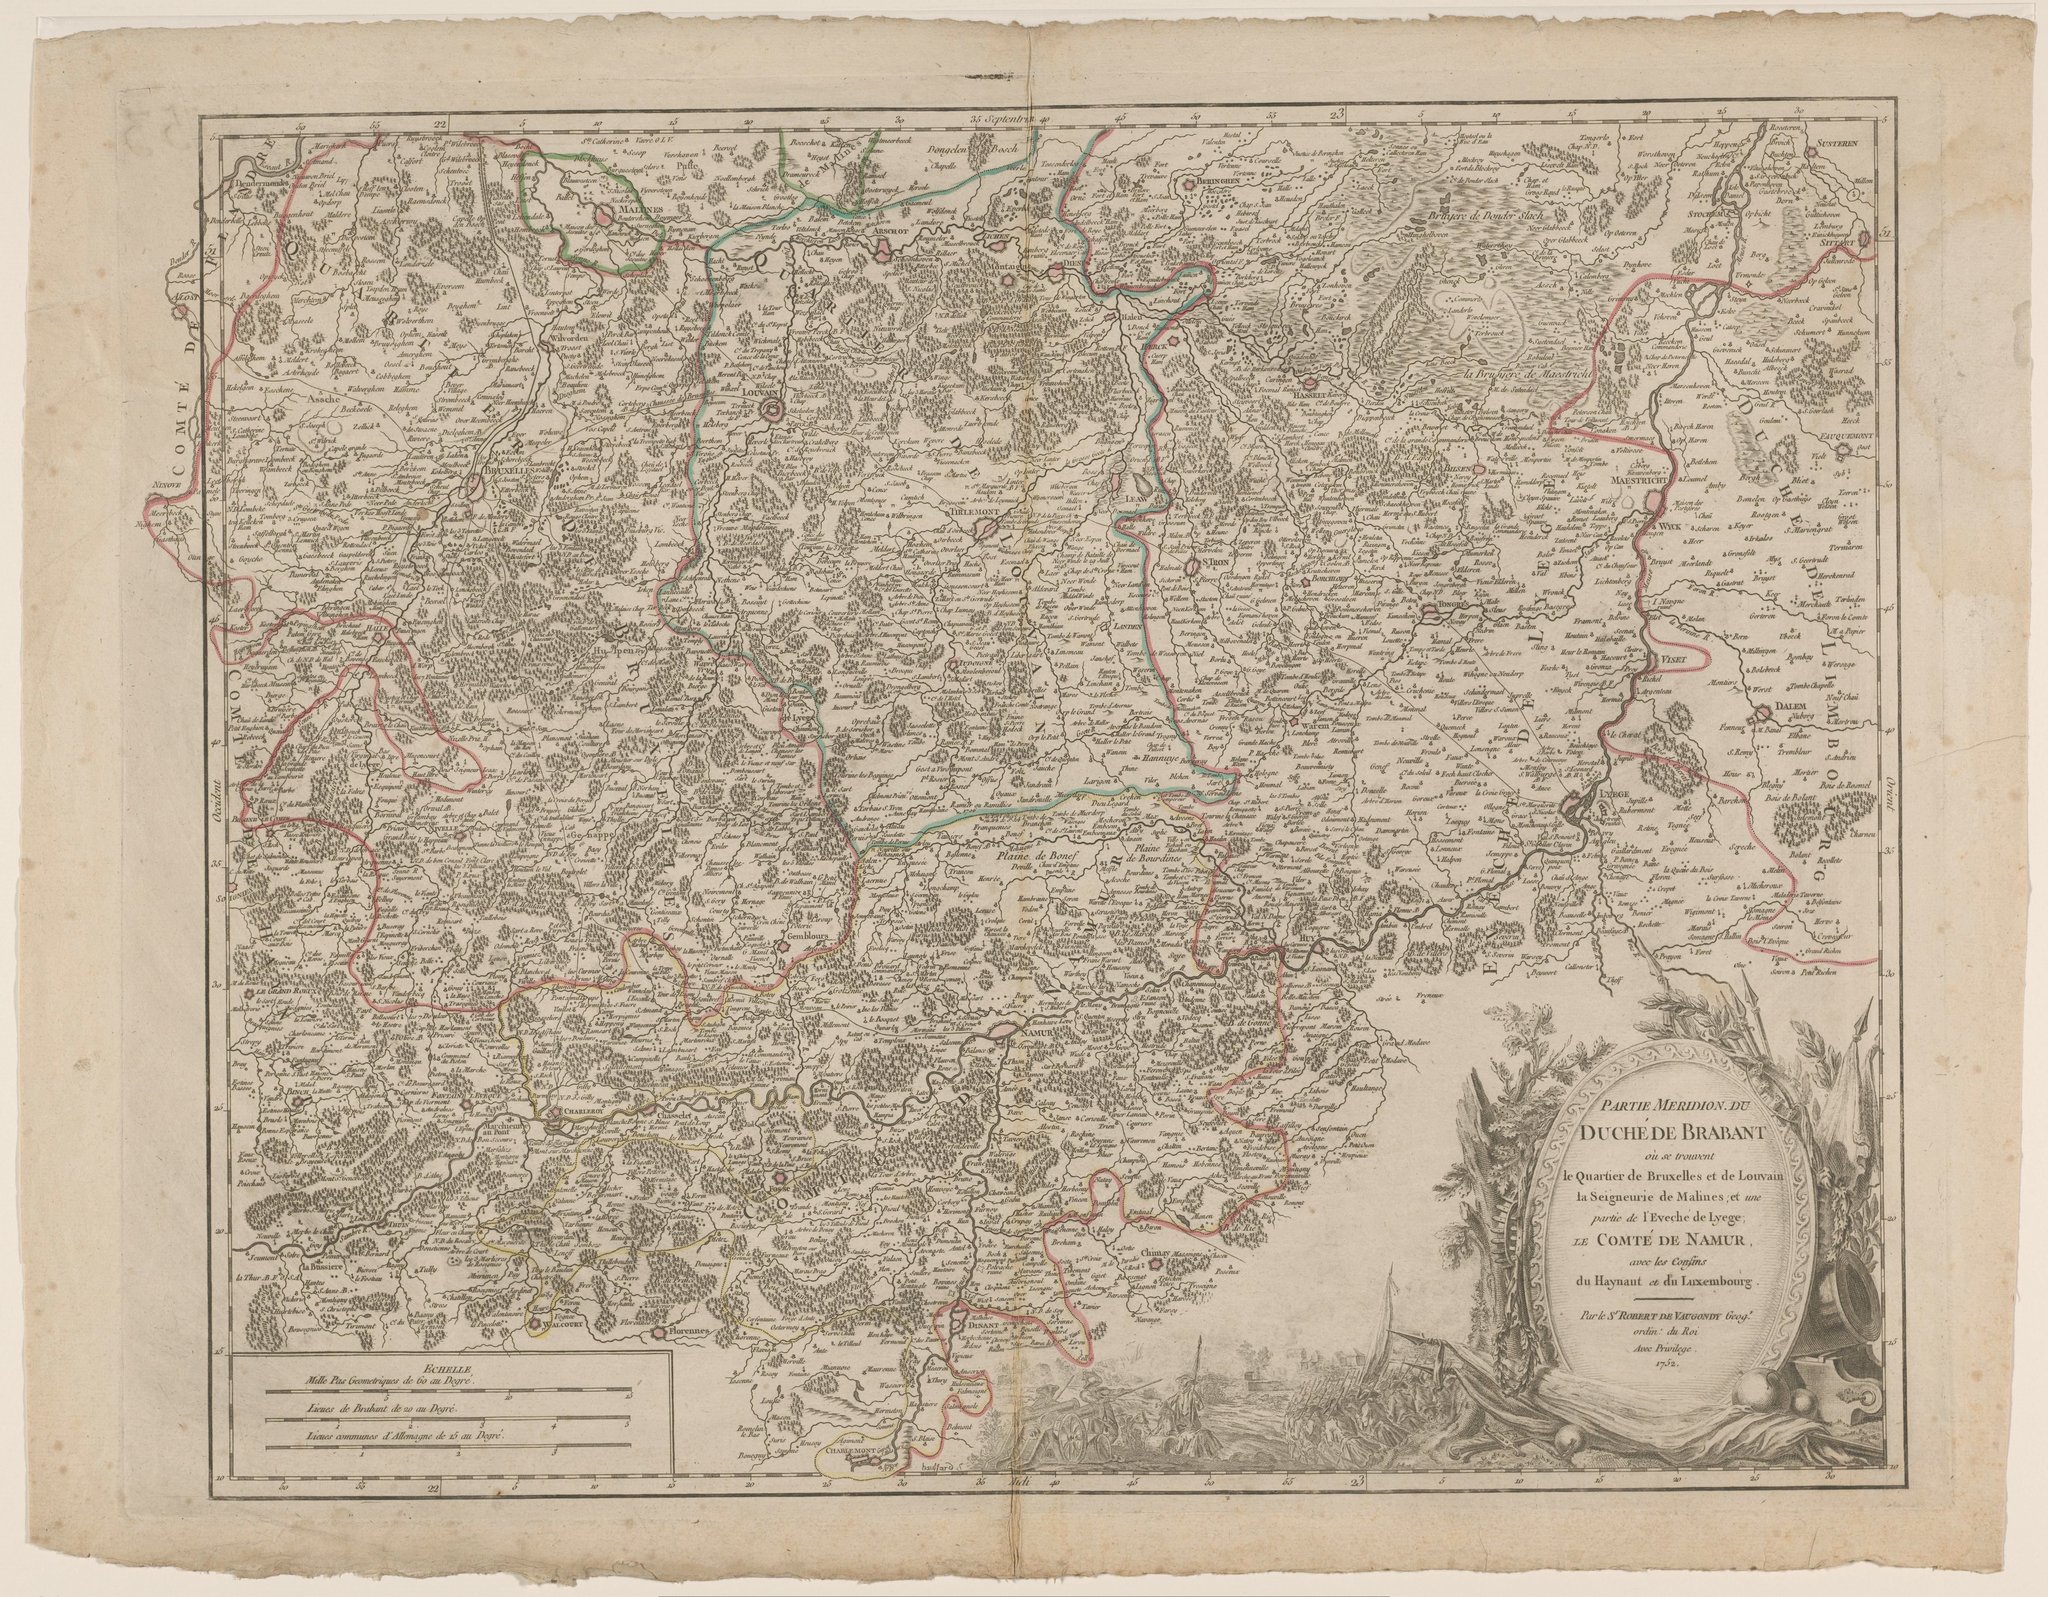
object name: map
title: Kaart van het zuidelijke deel van het hertogdom Brabant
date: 1752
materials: paper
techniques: engraving, etching, hand coloring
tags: maps of separate countries or regions, brabant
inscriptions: collector's mark: Lugt 2228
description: Kaart van het zuidelijke deel van het hertogdom Brabant. Rechtsonder de titelcartouche, met links een voorstelling van een leger dat ten strijde trekt. Linksonder een kader met drie schaalstokken: 15 Mille Pas Geometriques de 60 au Degré / 5 Lieues de Brabant de 20 au Degré / 3 Lieues communes d'Allemagne de 15 au Degré. De kaart is voorzien van een gradenverdeling langs de randen.